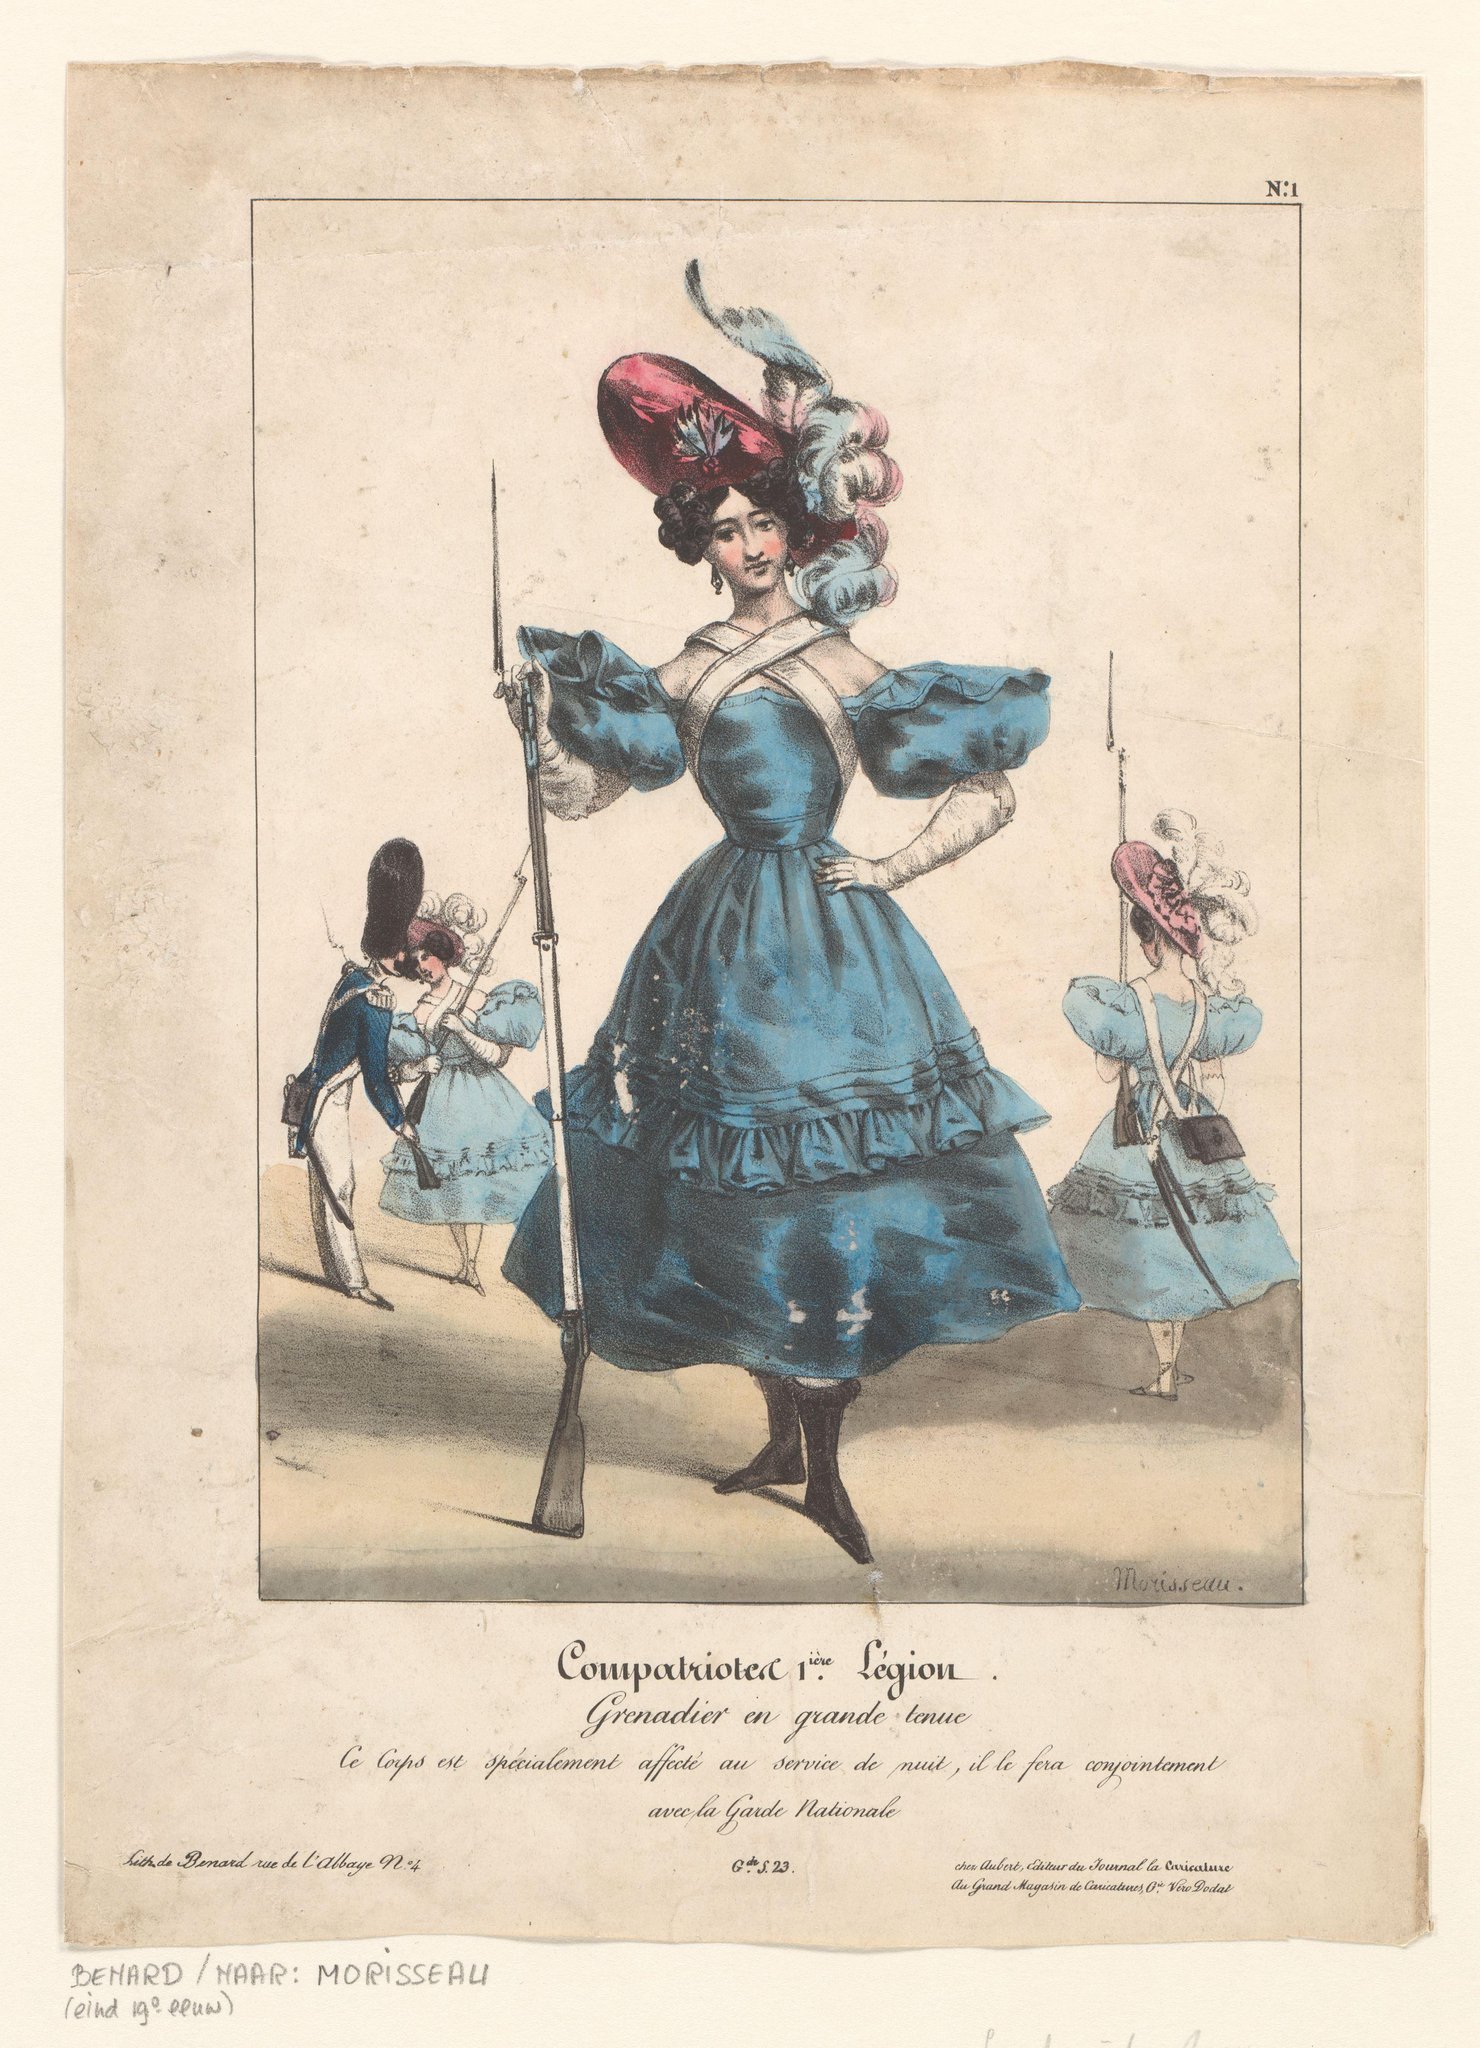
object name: cartoon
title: Compatriotes 1ière Légion. Grenadier au grande tenue / Ce corps est spécialement affecté au service de nuit ...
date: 1831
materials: paper, watercolor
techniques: hand coloring, lithograph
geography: paris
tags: whore, prostitute, dress, gown, (military) uniforms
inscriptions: collector's mark: Lugt 2228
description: Fantasiekostuum: uniform en bewapening voor vrouwelijke grenadier van het Eerste Legioen, vooral ingezet in de avonduren (als prostituees). Vrouw met geweer met bajonet, gekleed in blauwe japon en hoed met pluimen. Op de achtergrond ontmoet zij een militair van de Garde Nationale. Rechtsboven genummerd: No. 1. Onderaan vermeld: G.deS. 23.